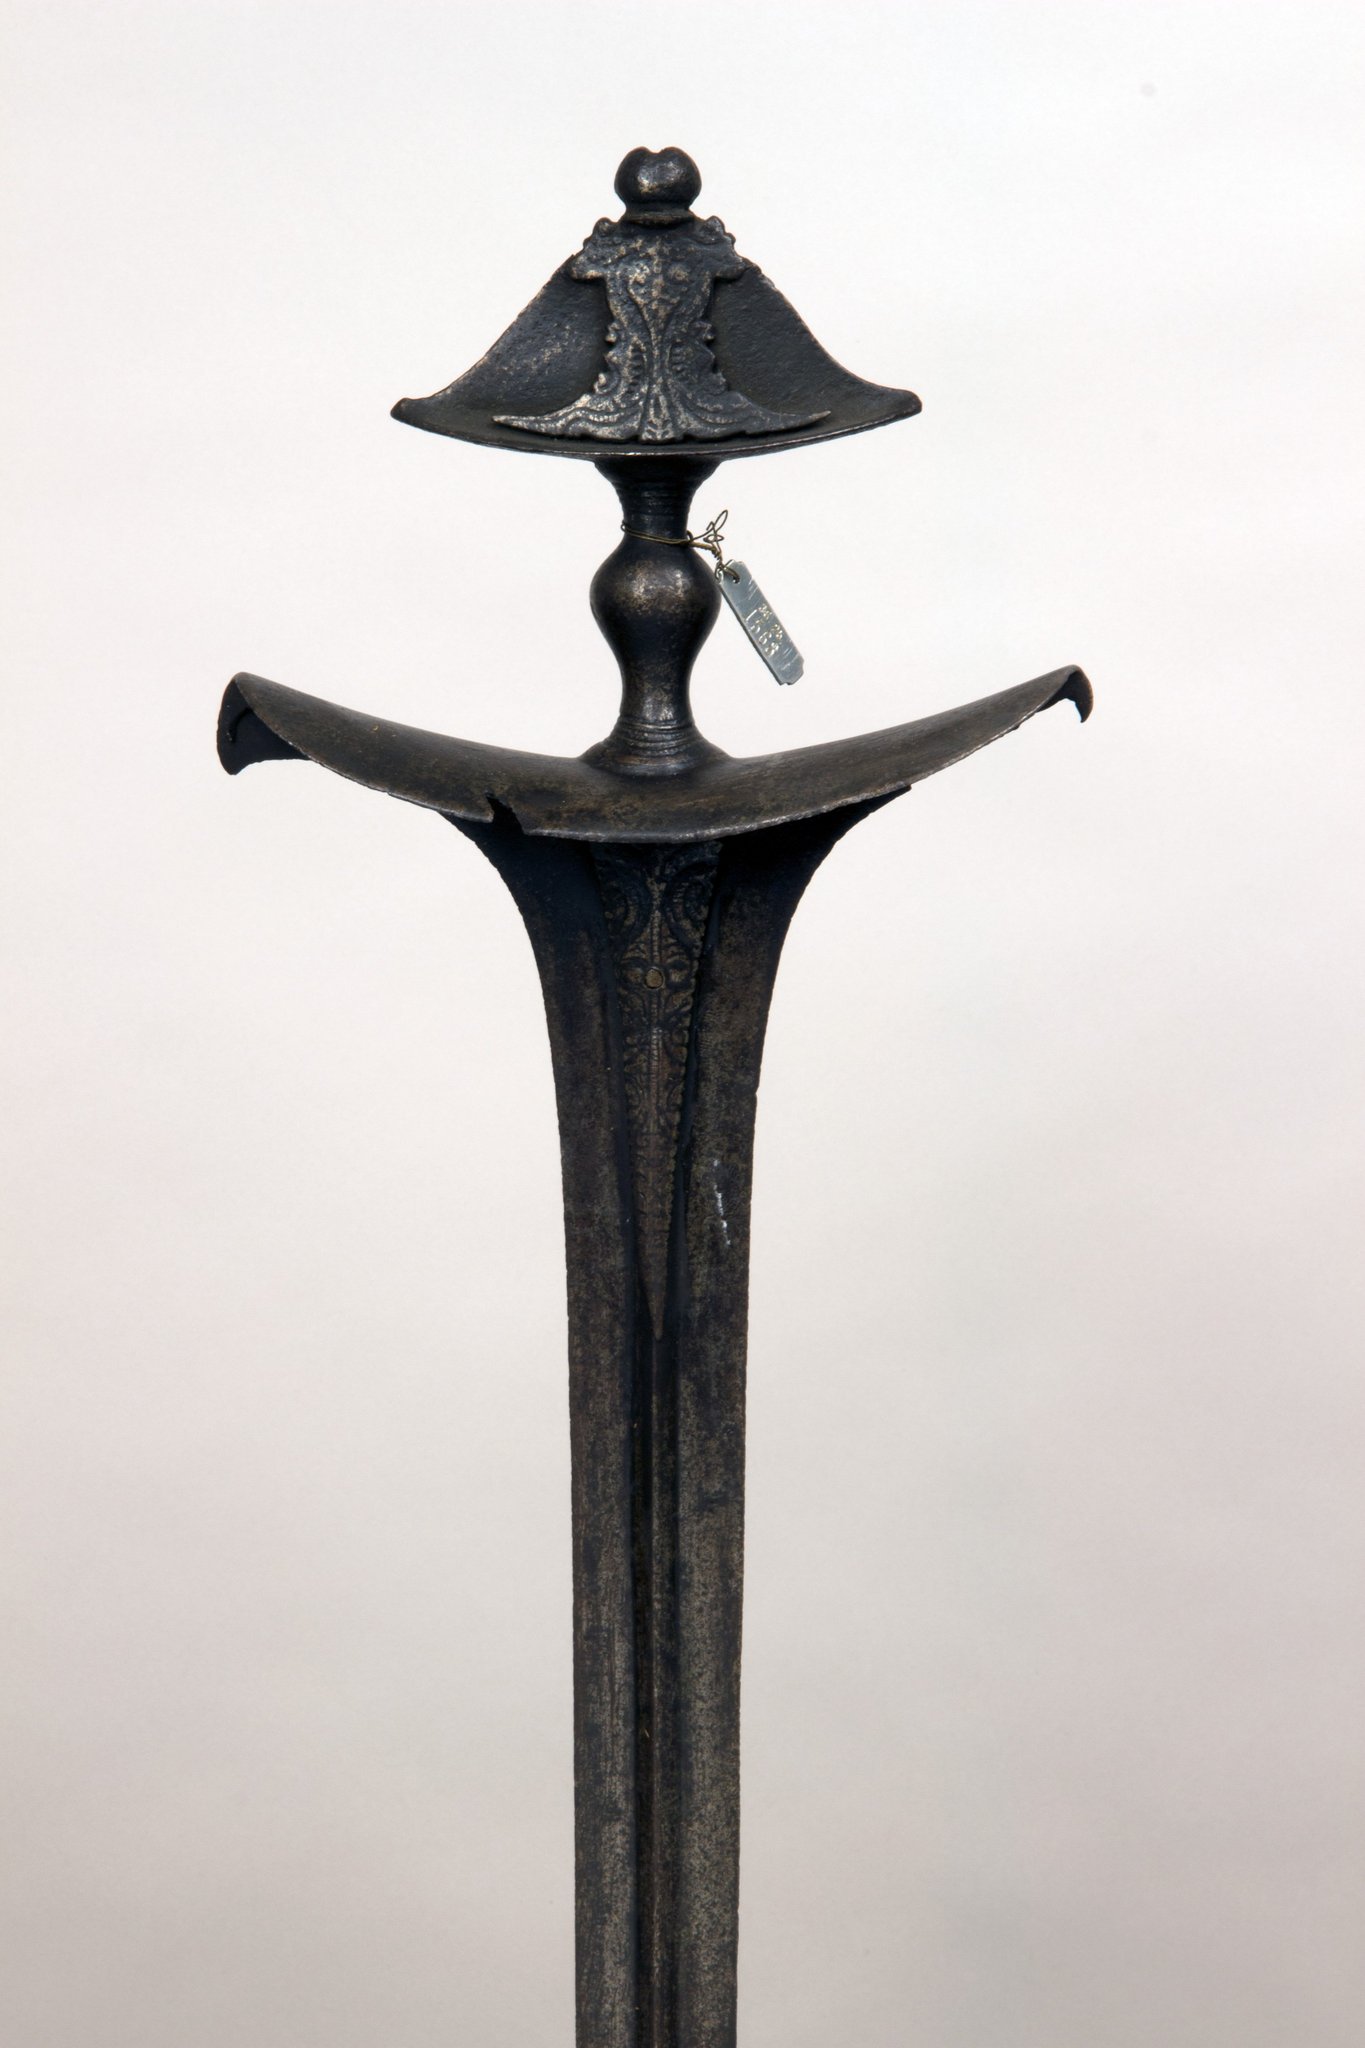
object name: sword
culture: indian, south indian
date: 1601-1700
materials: iron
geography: south india